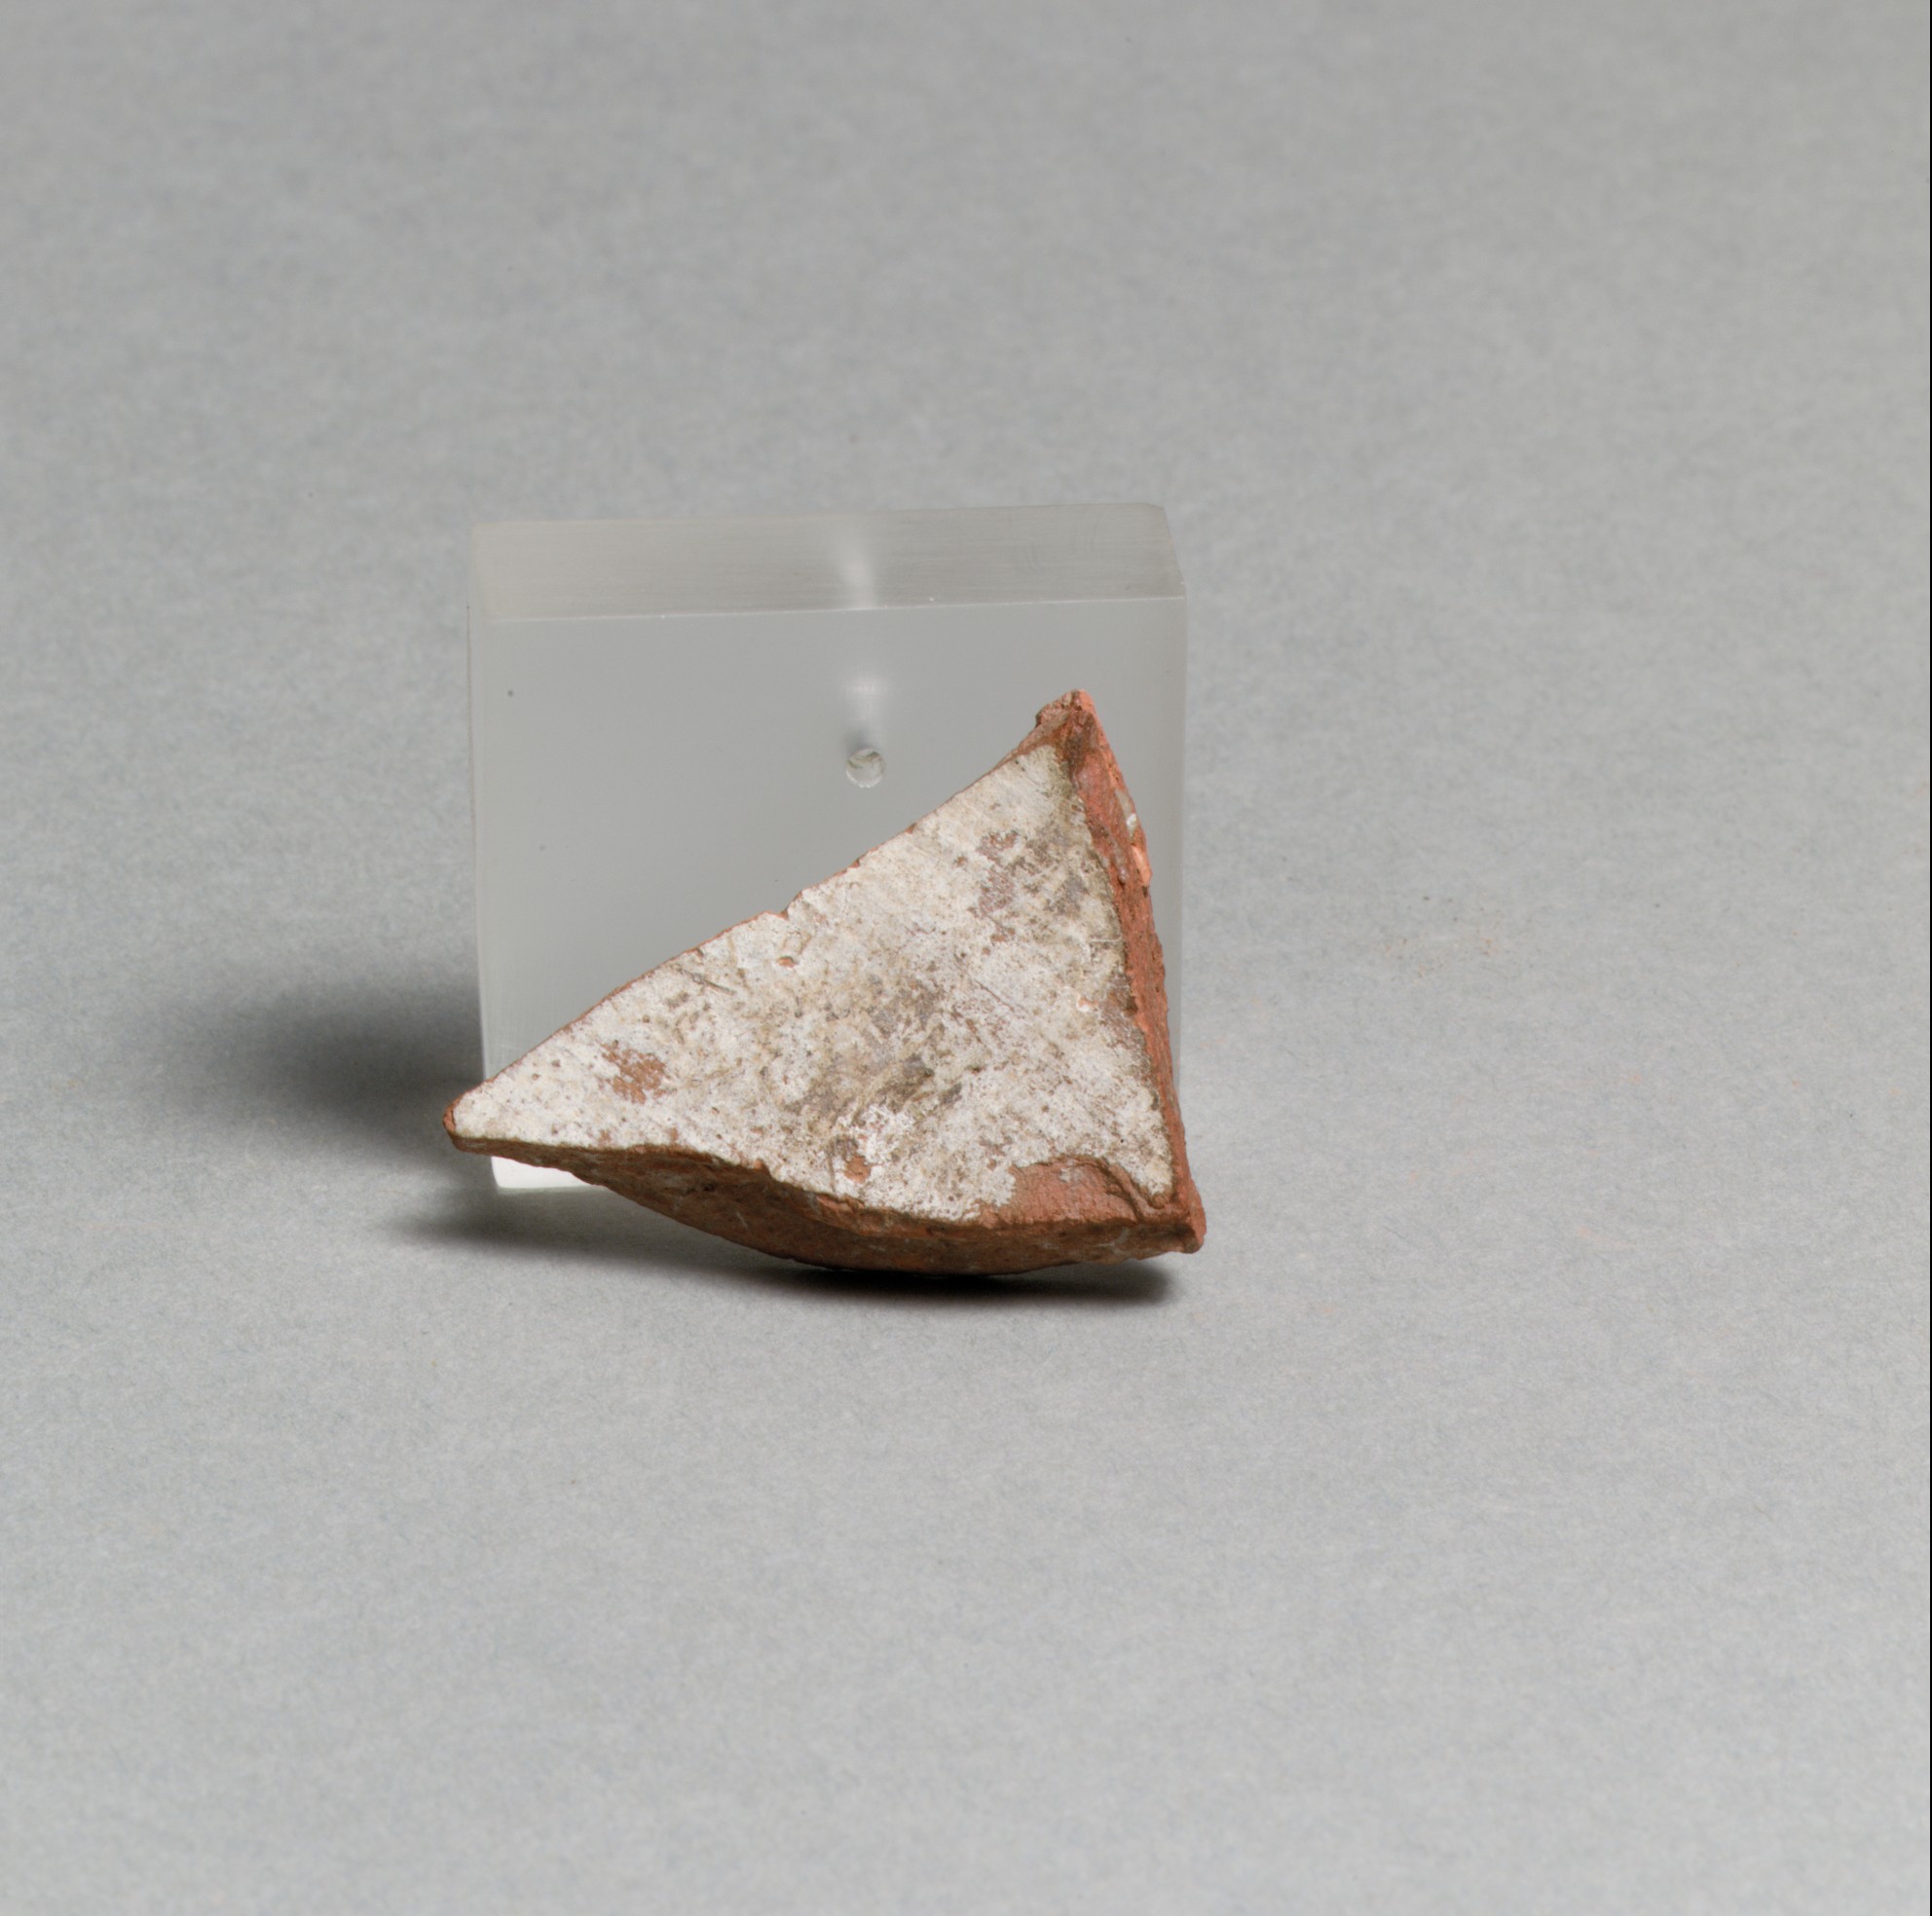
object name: vase fragment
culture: greek or lydian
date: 1050-700 BCE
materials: terracotta